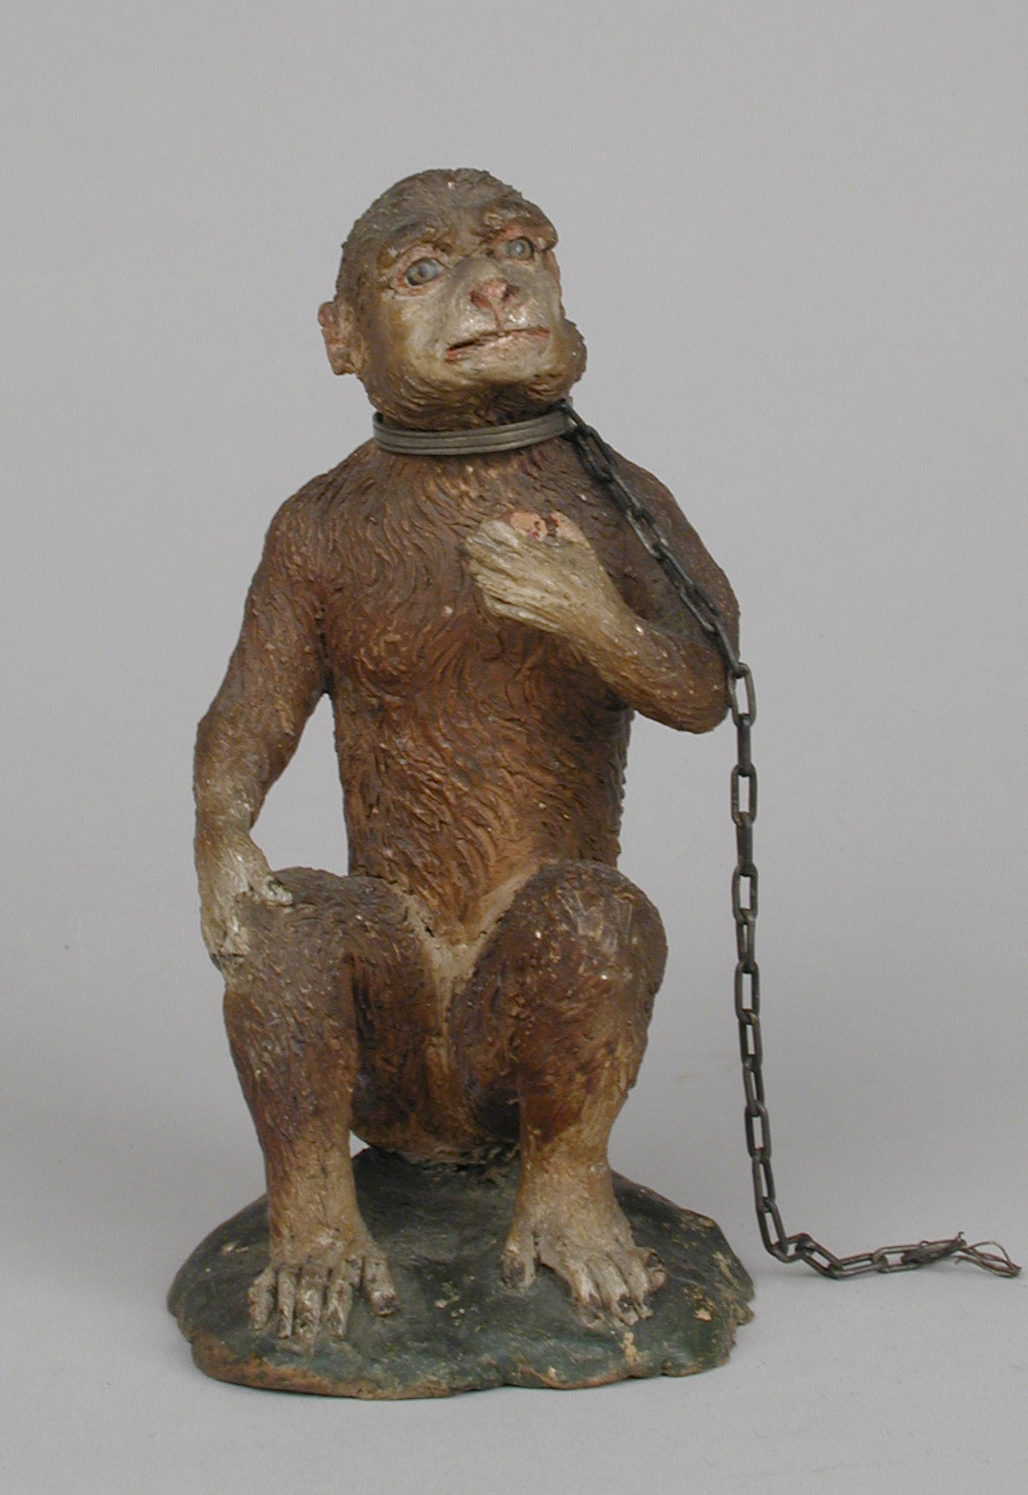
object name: crèche figure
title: Seated monkey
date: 1701-1900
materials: silver, terracotta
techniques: polychrome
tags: monkeys